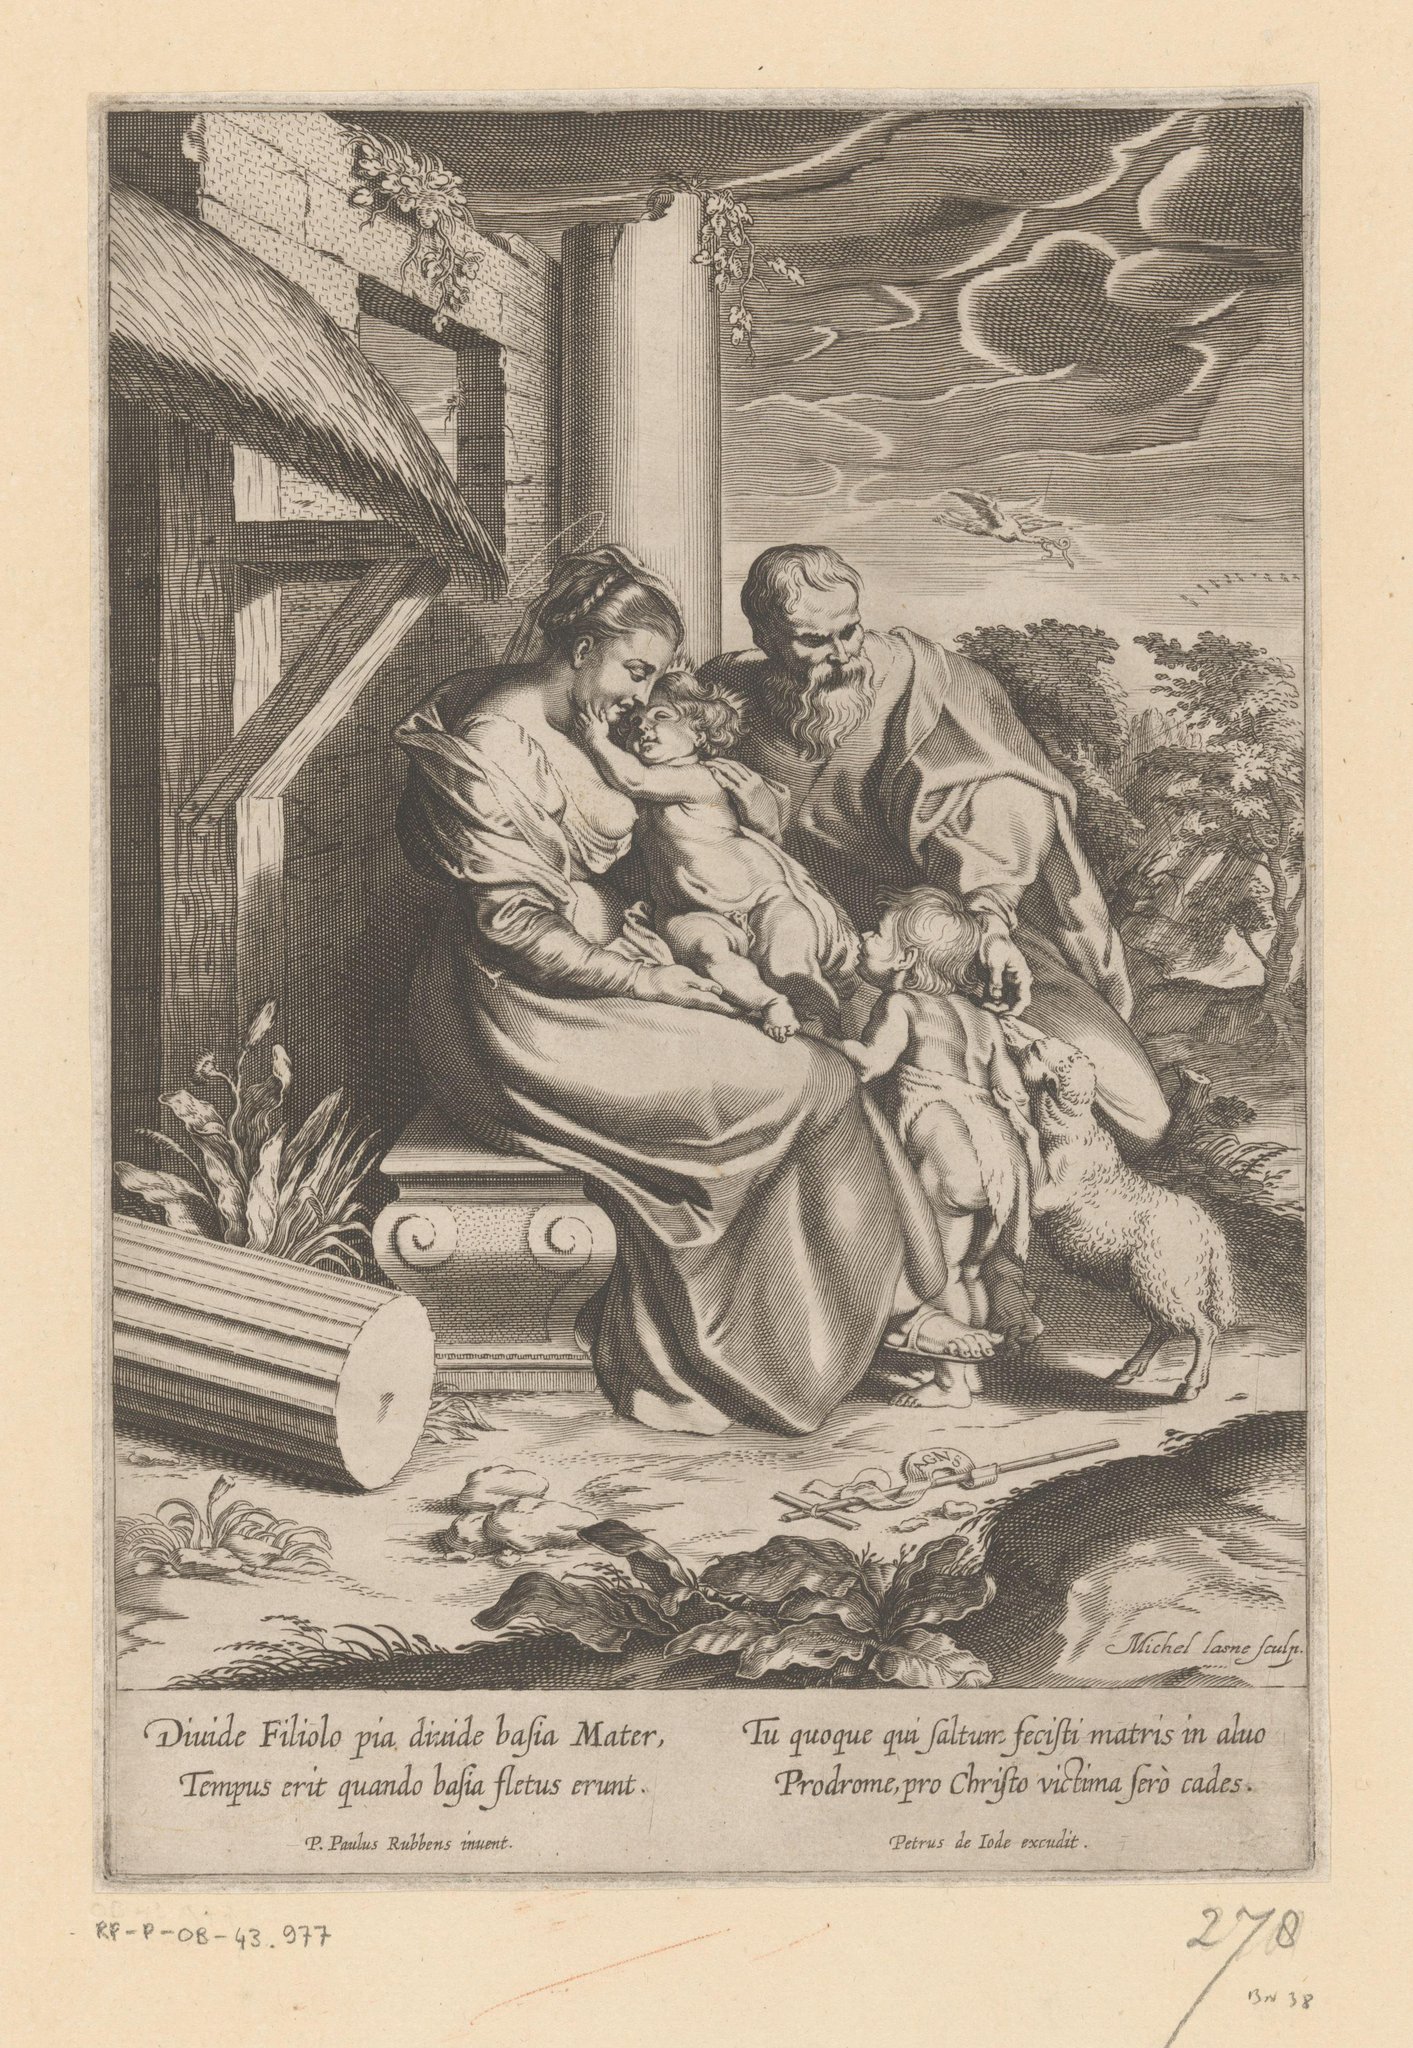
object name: print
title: Heilige Familie met Johannes de Doper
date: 1600-1634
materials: paper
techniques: engraving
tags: holy family with john the baptist (as child)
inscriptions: collector's mark: Lugt 240